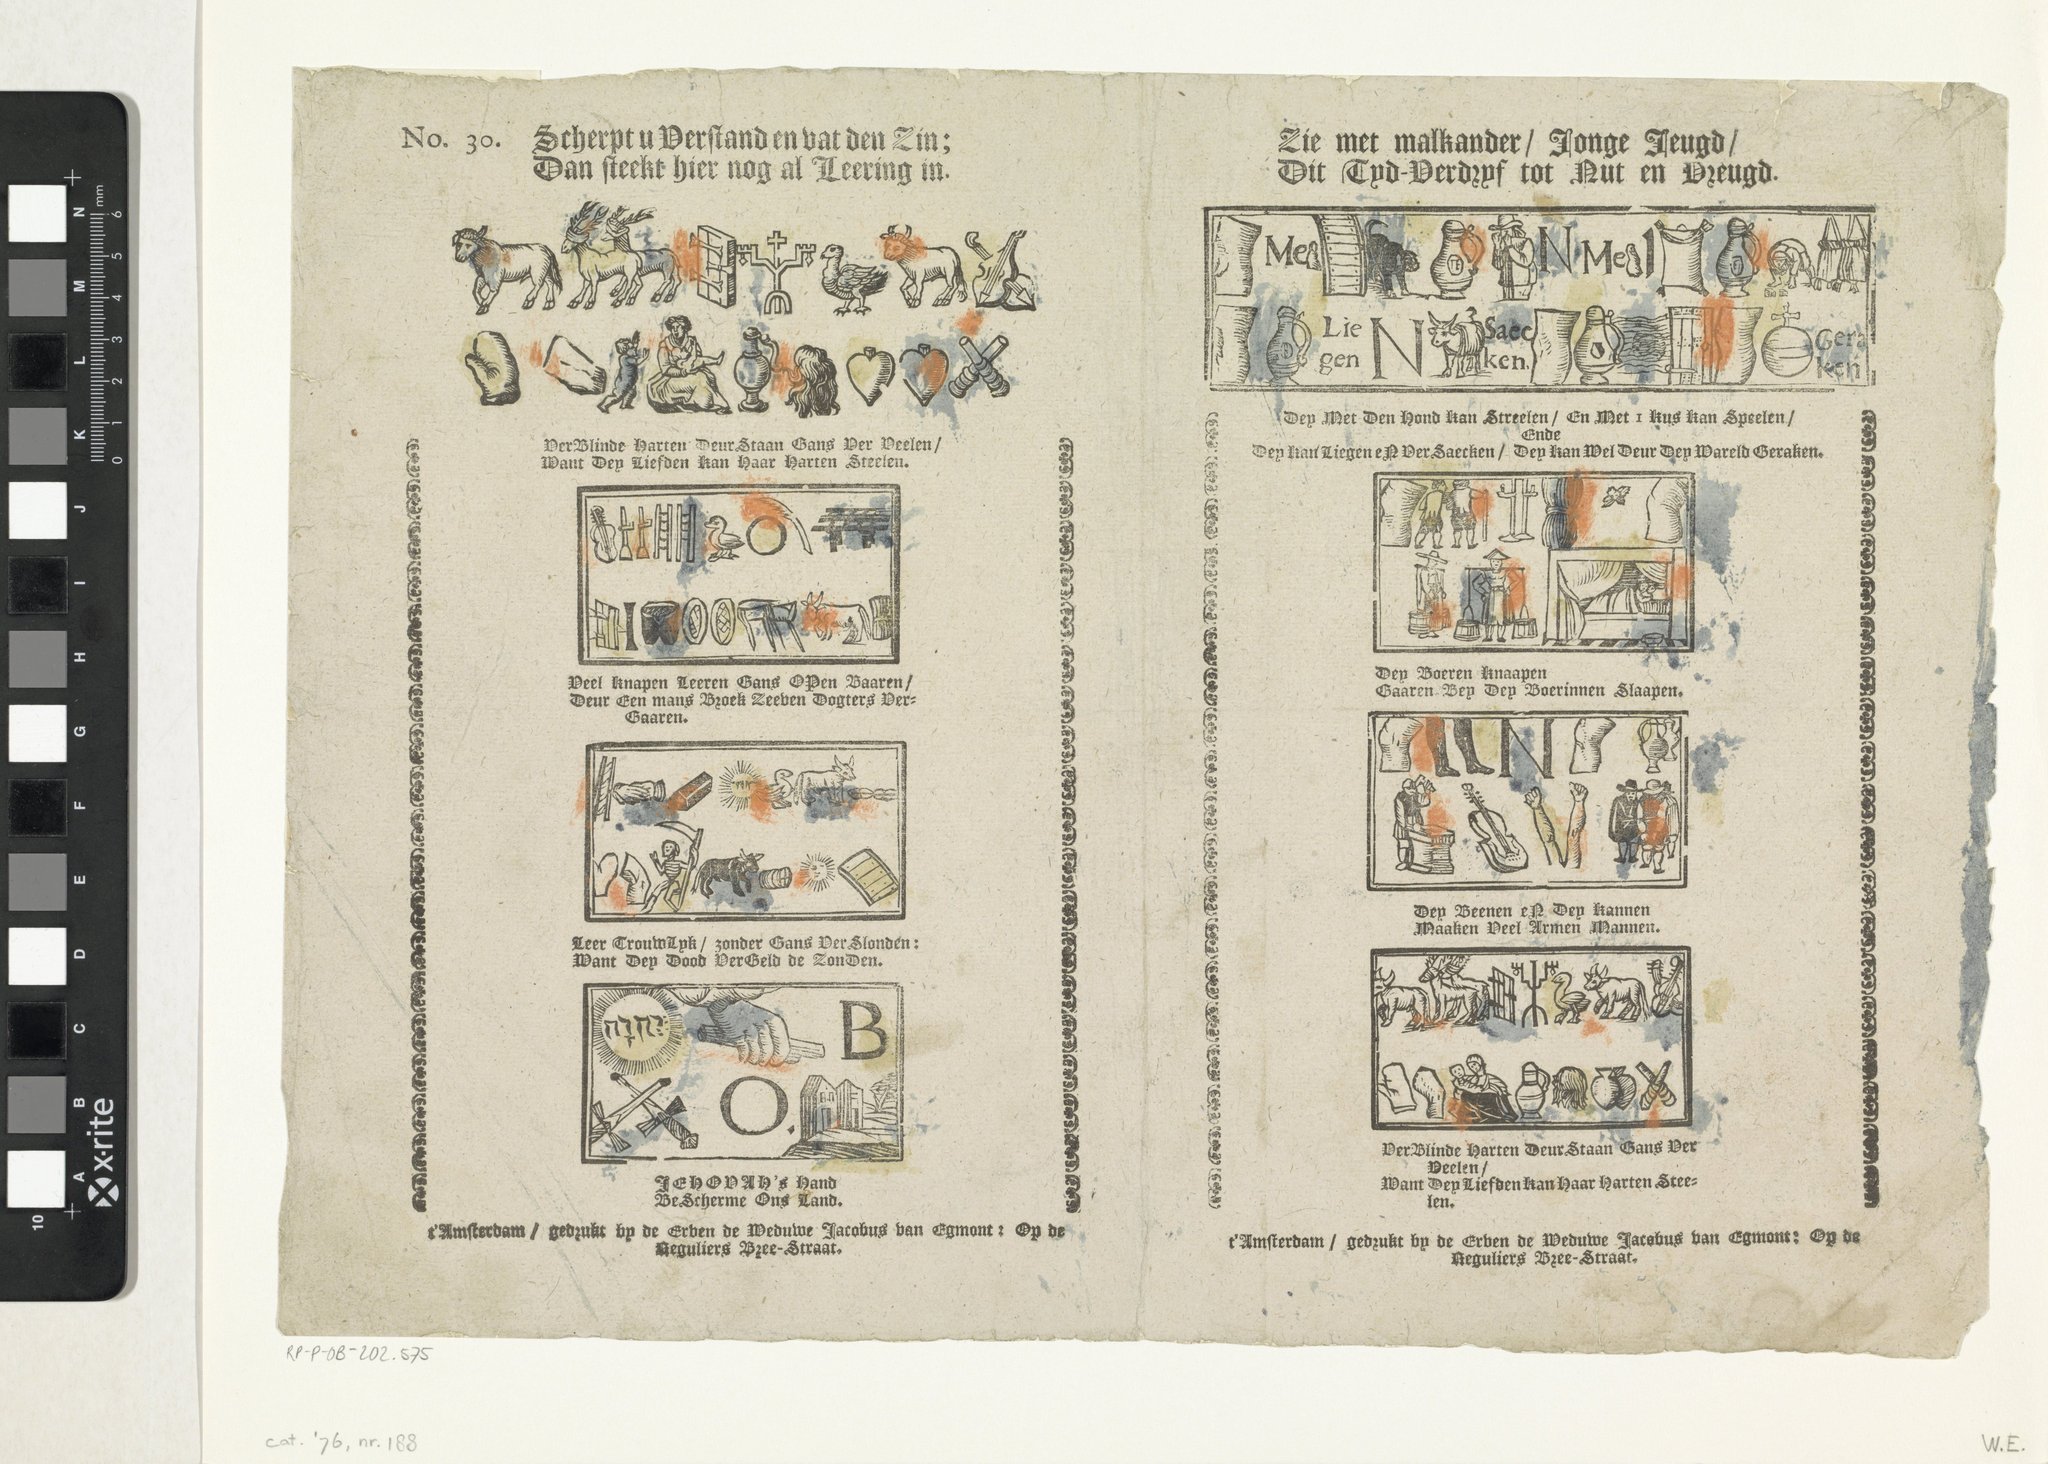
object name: print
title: Scherpt u verstand en vat den zin; / Dan steekt hier nog al leering in / Ziet met malkander / jonge Jeugd / Dit tyd-verdryf tot nut en vreugd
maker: Anonymous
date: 1761-1804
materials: paper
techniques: colour, letterpress printing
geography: amsterdam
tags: rebus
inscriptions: collector's mark: Lugt 2760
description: Blad met 8 voorstellingen van rebussen. Onder elke rebus wordt de oplossing gegeven. Genummerd linksboven: No. 30.